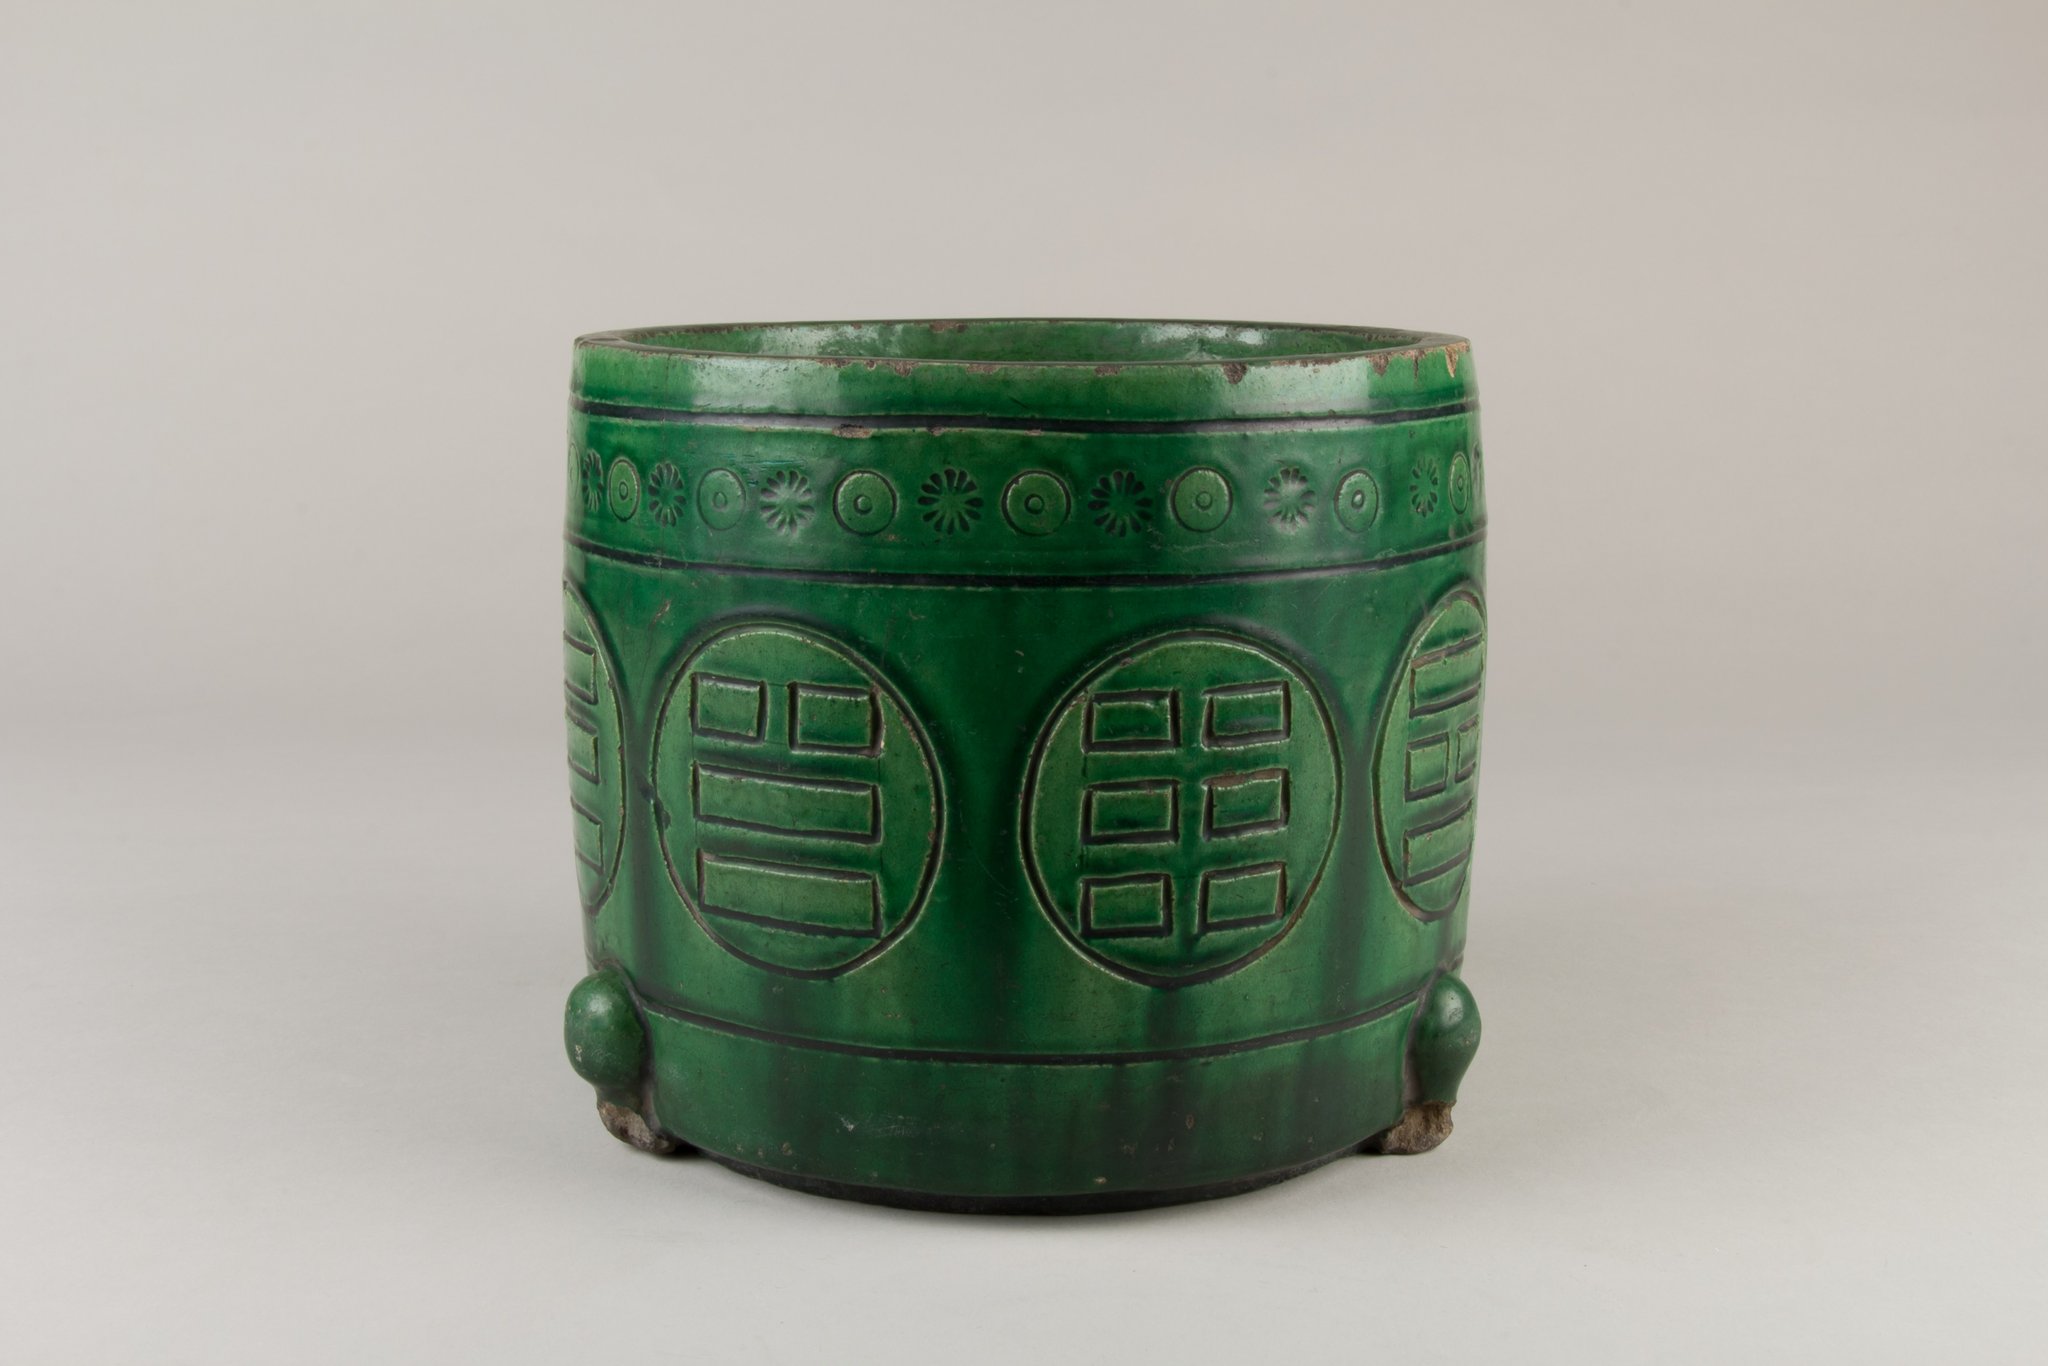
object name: incense burner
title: Tripod incense burner with the Eight Trigrams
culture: chinese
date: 1501-1600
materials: glaze, stoneware